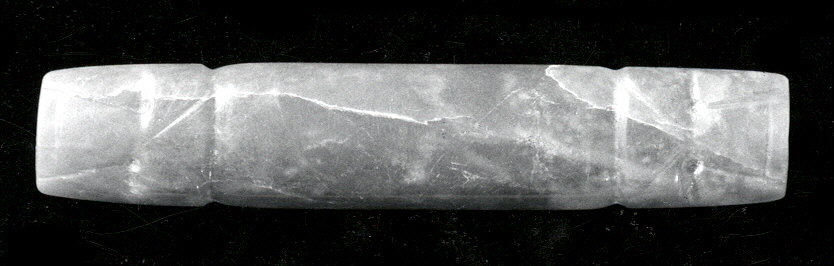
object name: bead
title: Tubular Bead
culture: atlantic watershed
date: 301-800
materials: jade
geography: costa rica